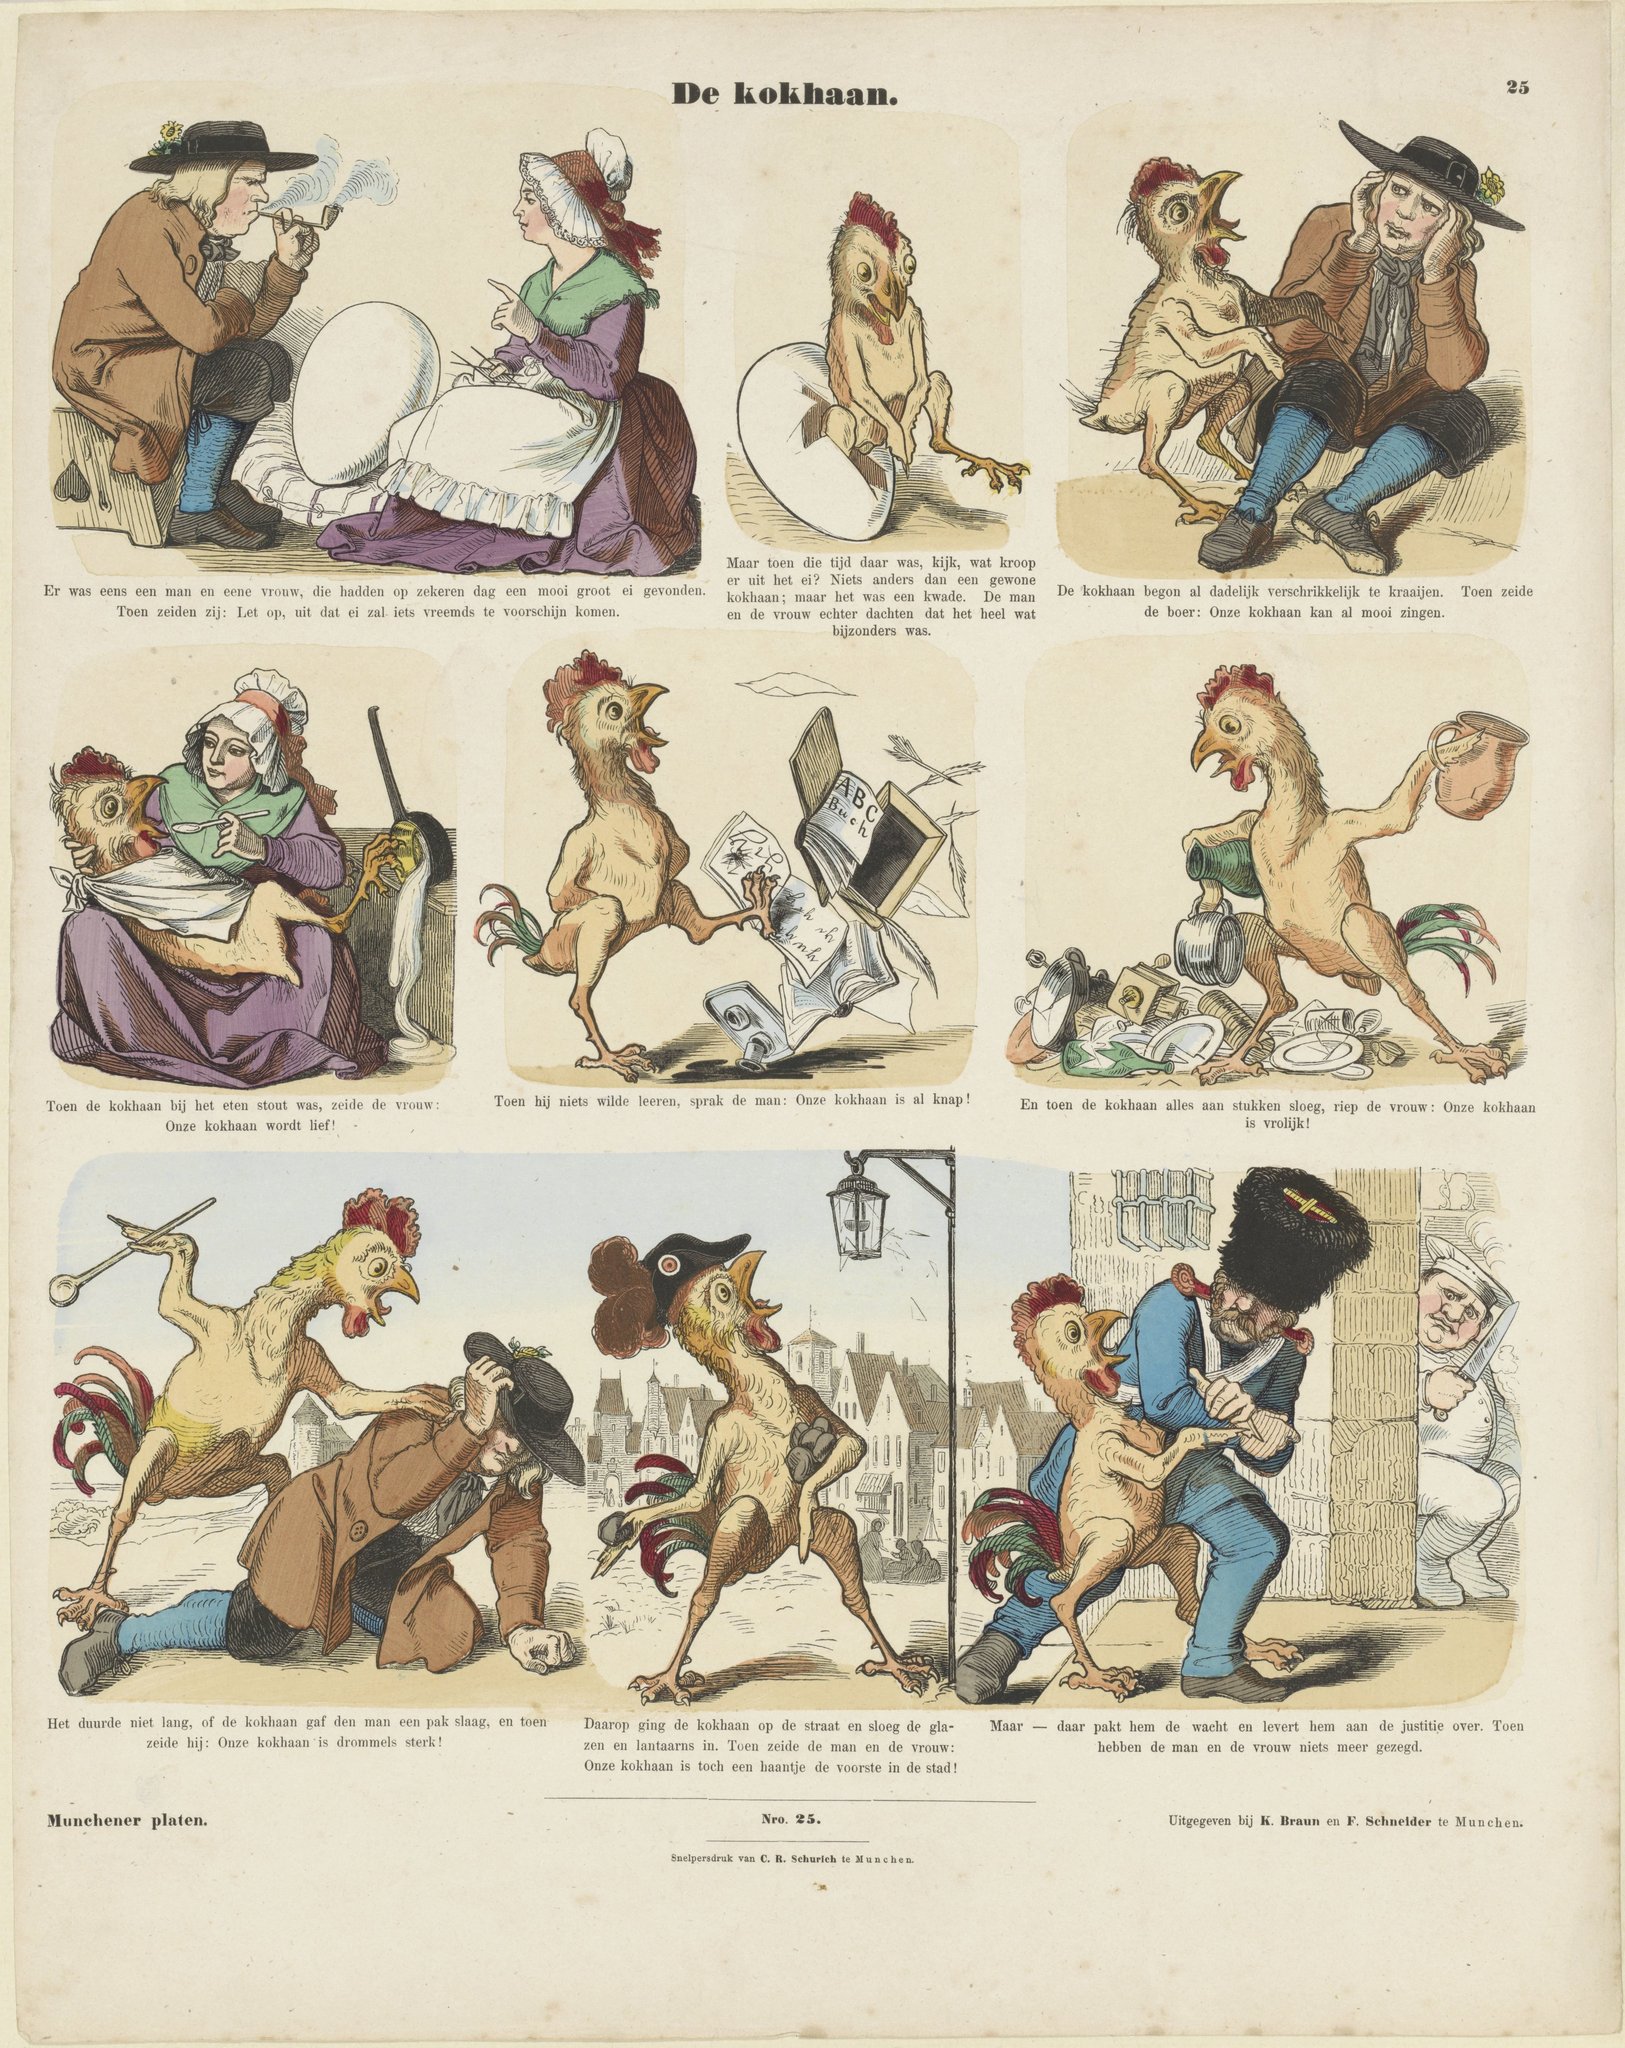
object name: print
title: De kokhaan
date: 1843-1920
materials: paper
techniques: colour, letterpress printing, engraving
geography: germany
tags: fowl (cock, hen, chicken, etc.)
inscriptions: collector's mark: Lugt 2760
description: Blad met 9 voorstellingen over het leven van een haan. De haan wordt zo verwend dat hij het slechte pad op gaat. Het loopt slecht met hem af. Onder elke afbeelding een onderschrift. Genummerd midden onder: Nr. 25. Genummerd rechtsboven: 25.